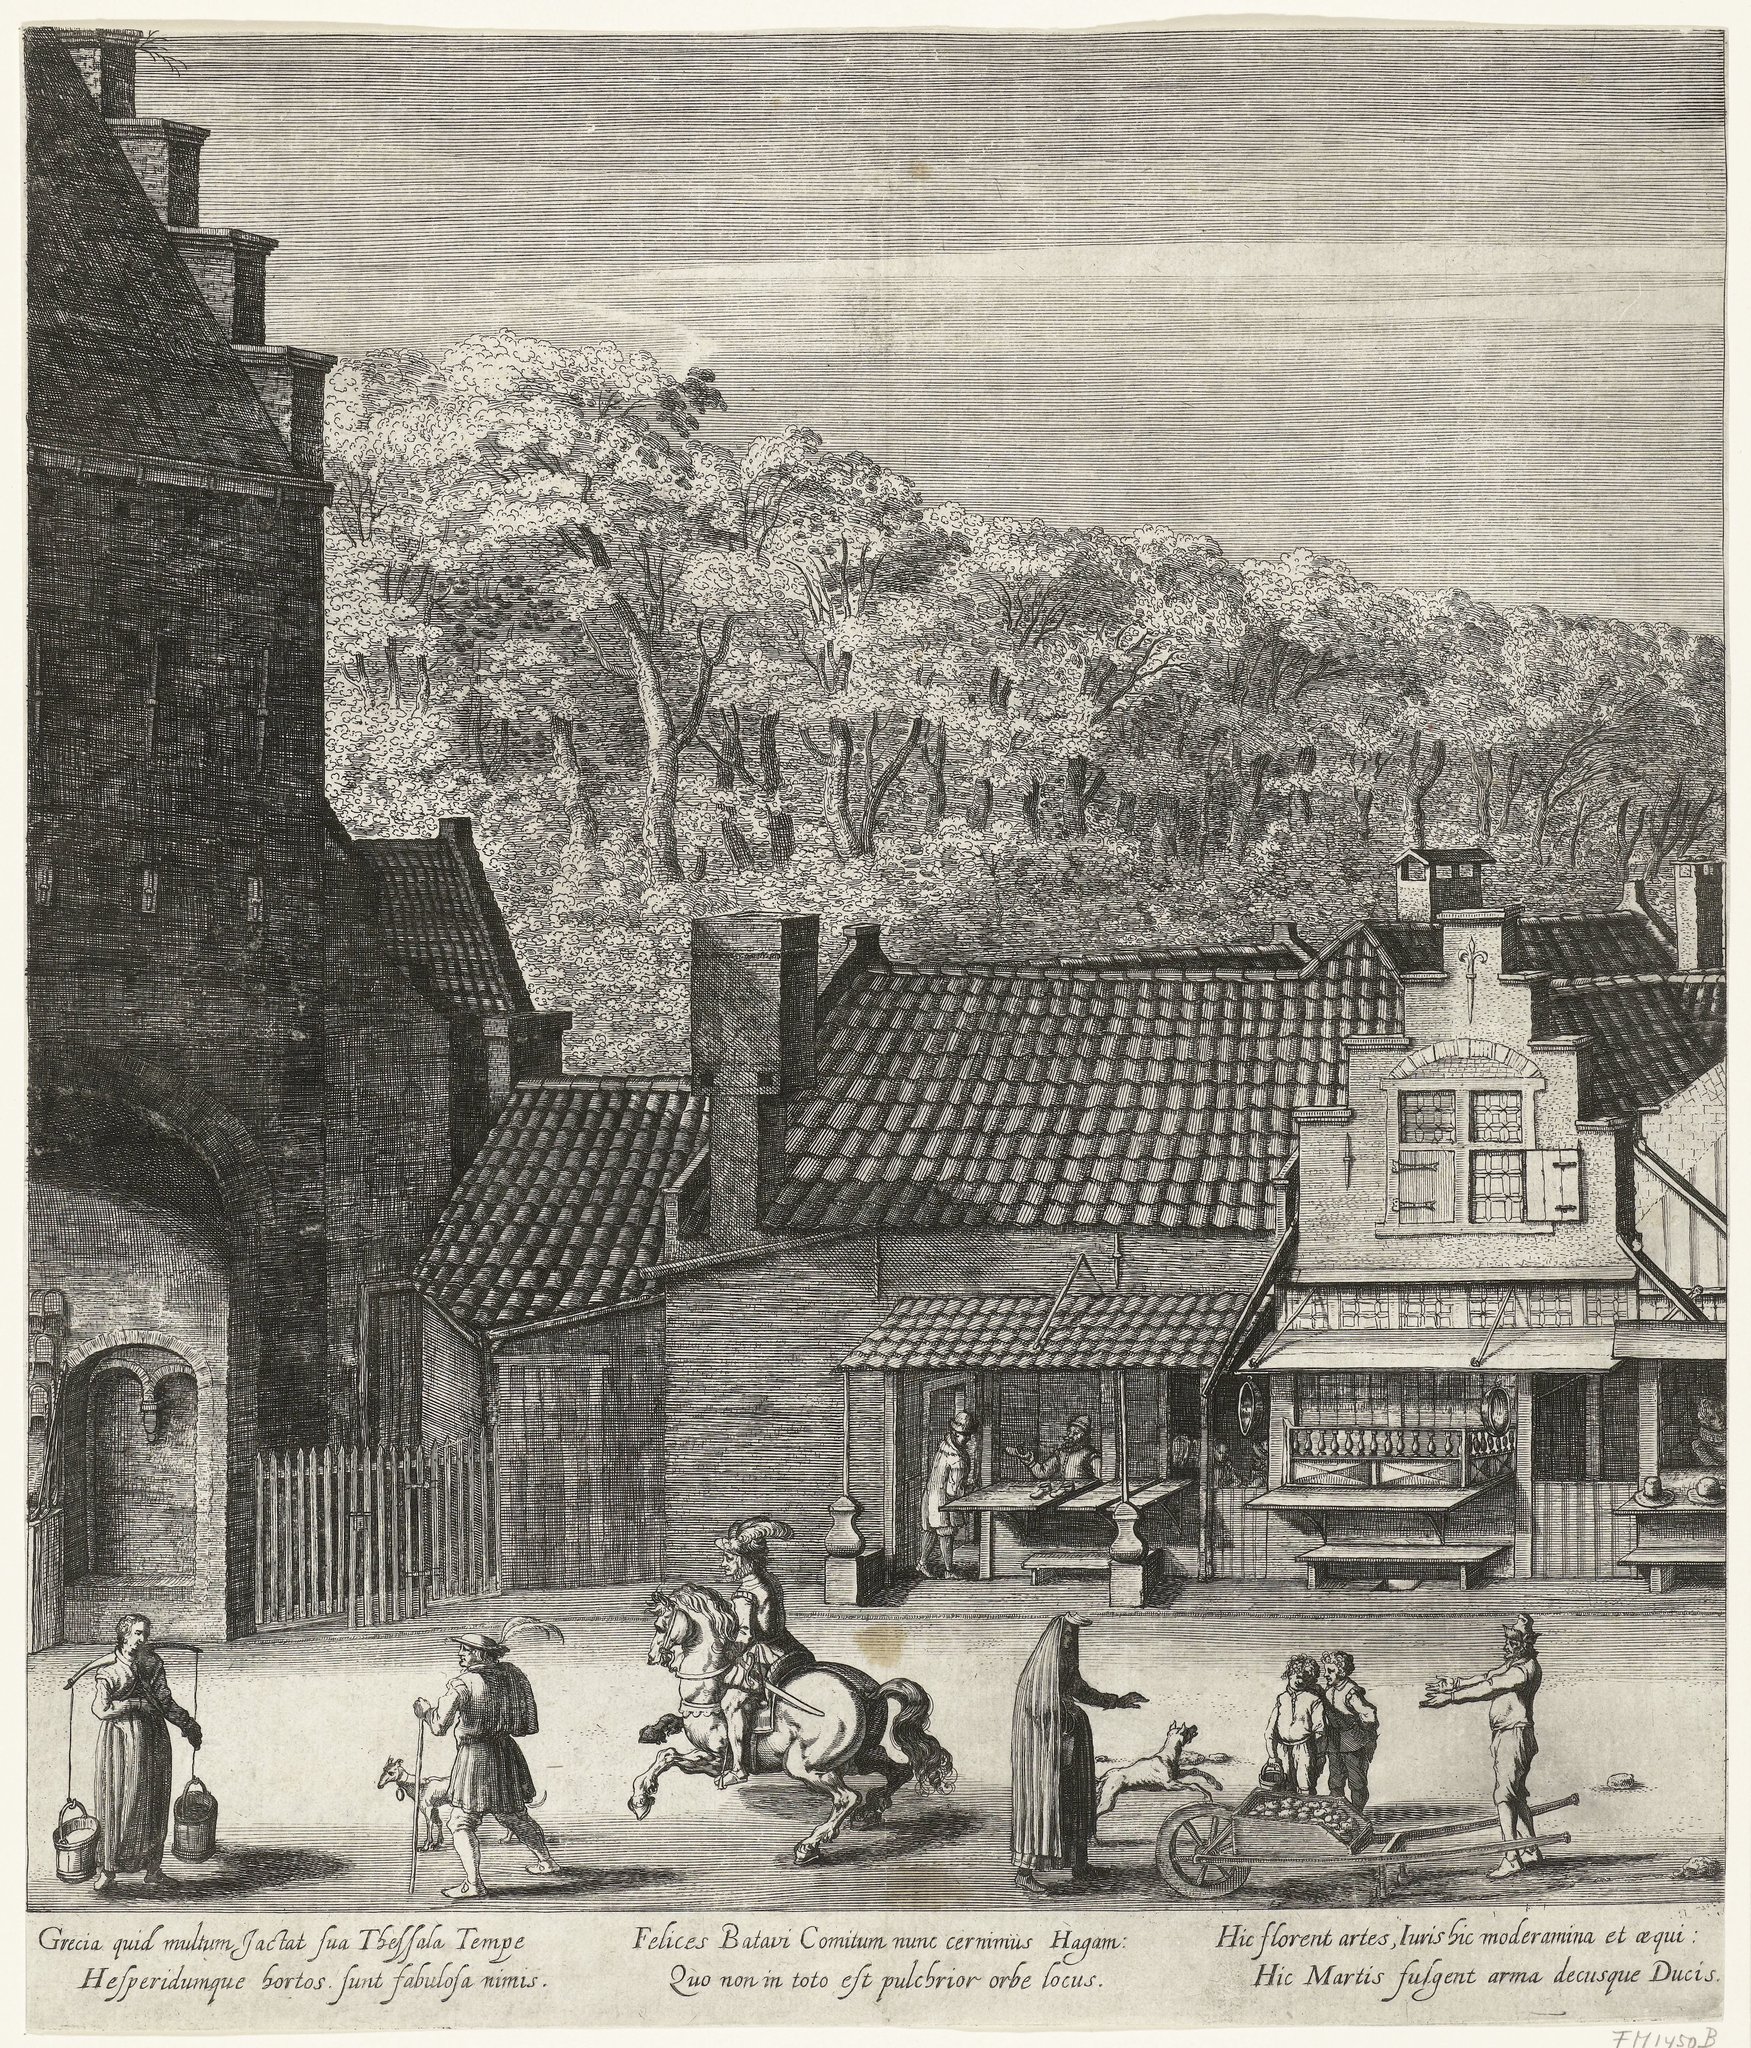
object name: print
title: Gezicht op het Binnenhof en de Hofvijver, 1621 (linkerblad)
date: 1621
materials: paper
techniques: engraving, etching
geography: northern netherlands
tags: binnenhof, hofvijver, gevangenpoort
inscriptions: date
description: Gezicht op het Binnenhof en de Hofvijver te Den Haag, in drie platen (linkerblad), 1621. Links de Gevangenpoort, op de voorgrond enkele winkeltjes. In het onderschrift 3 keer 2 regels in het Latijn.